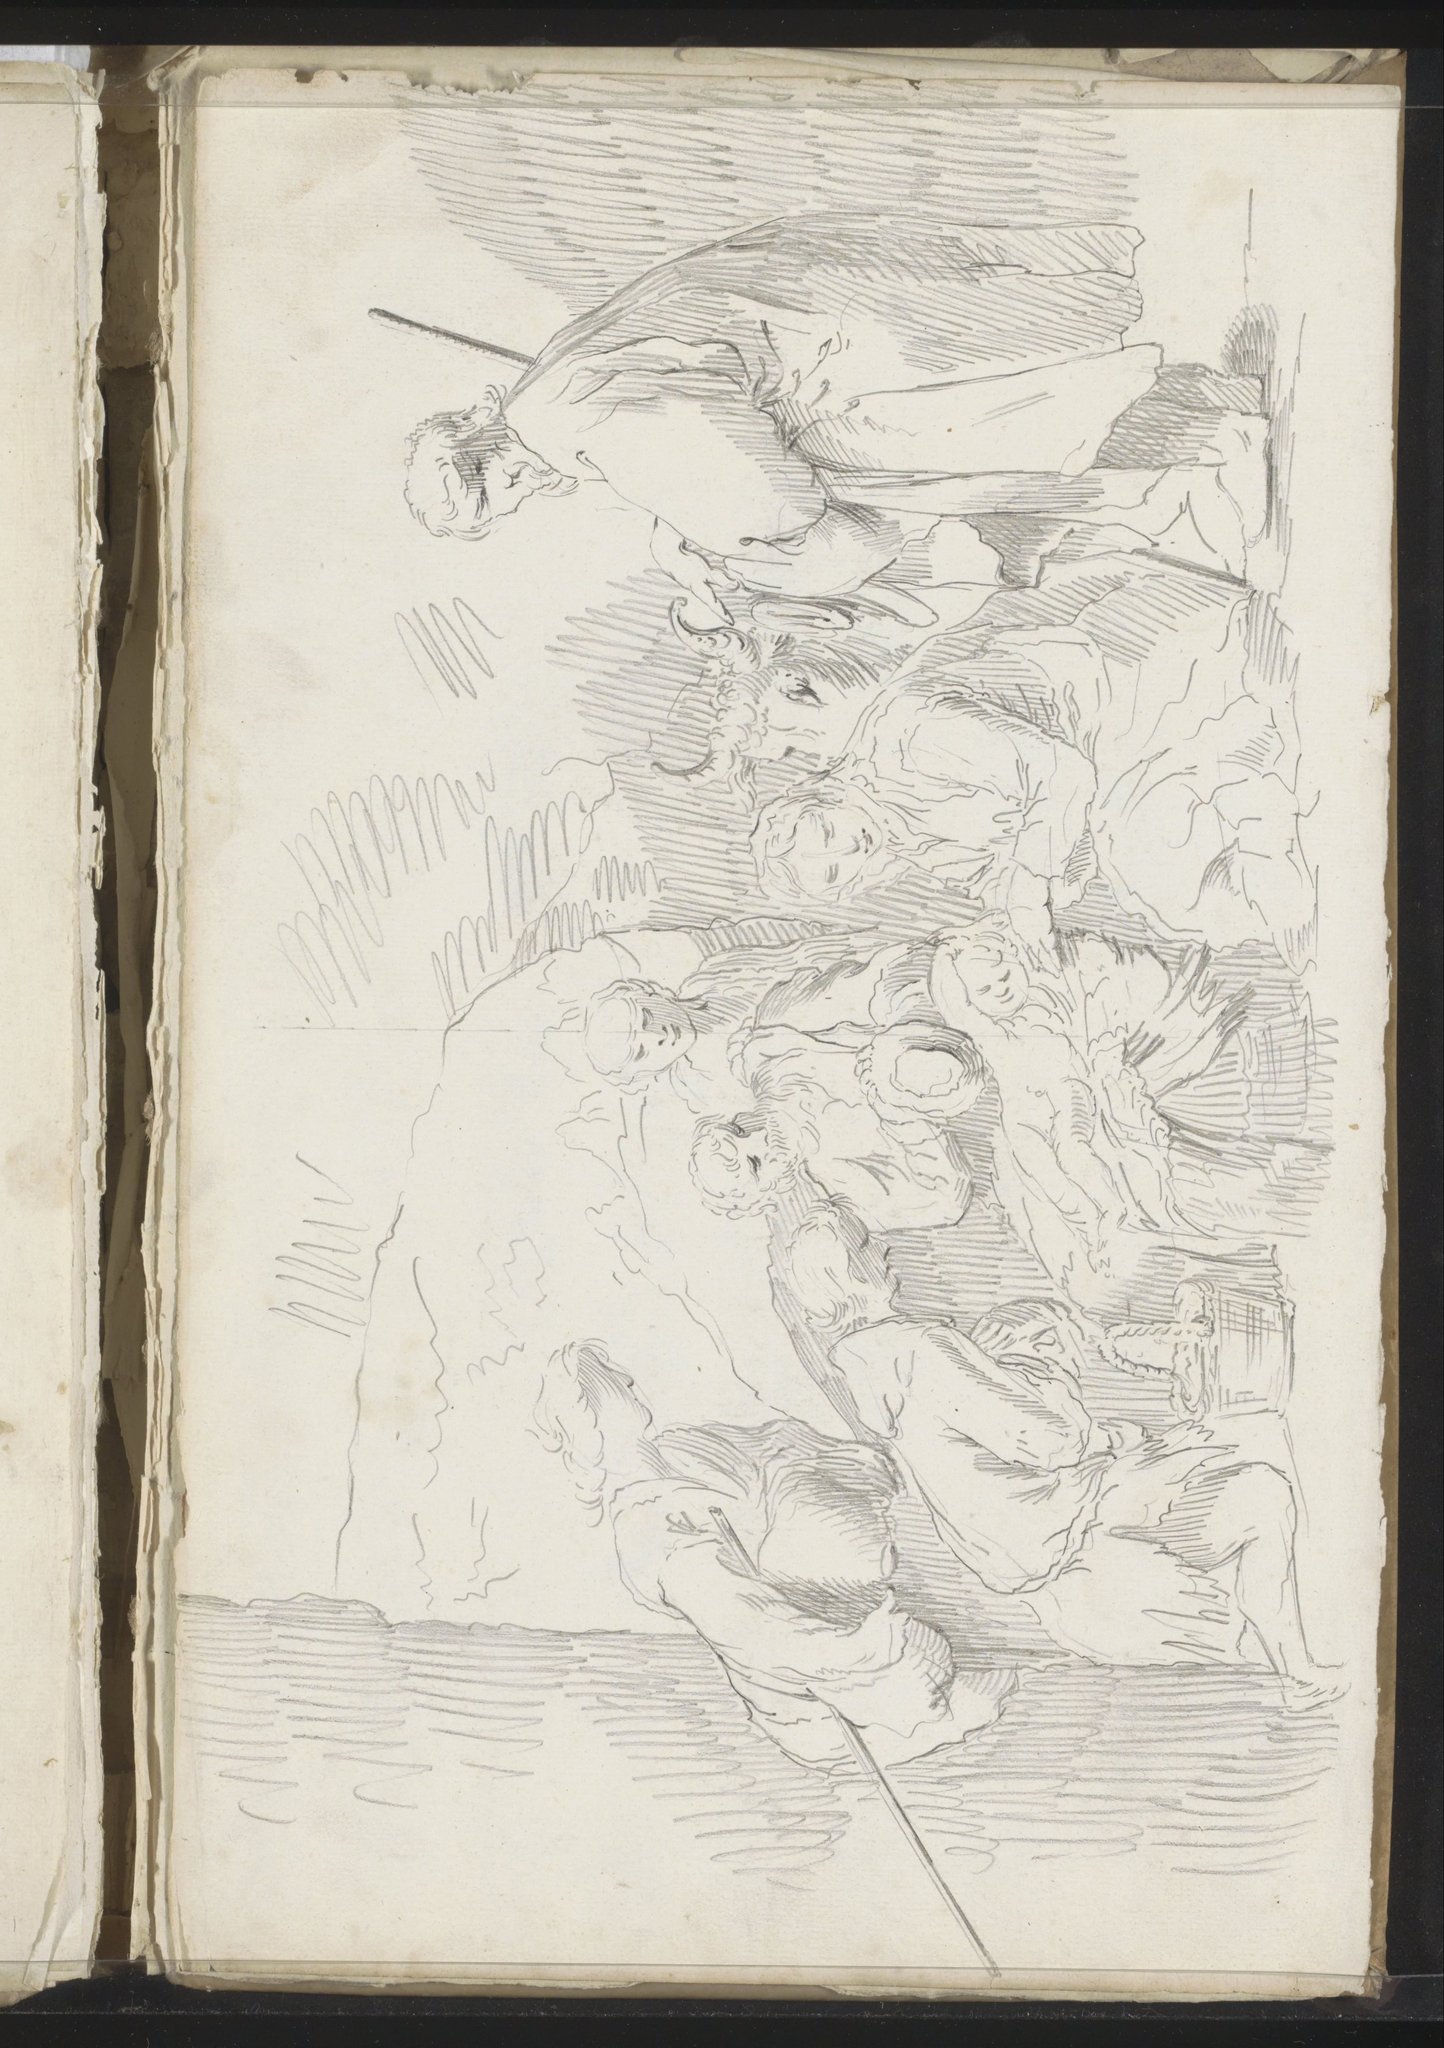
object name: sketchbook leaf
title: Geboorte van Christus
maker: jacob toorenvliet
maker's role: draughtsman, painter, print maker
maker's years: 1640-1719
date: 1701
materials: paper, pencil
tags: adoration of the christ-child ~ christ's birth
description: Blad 63 recto uit een schetsboek met 63 bladen.